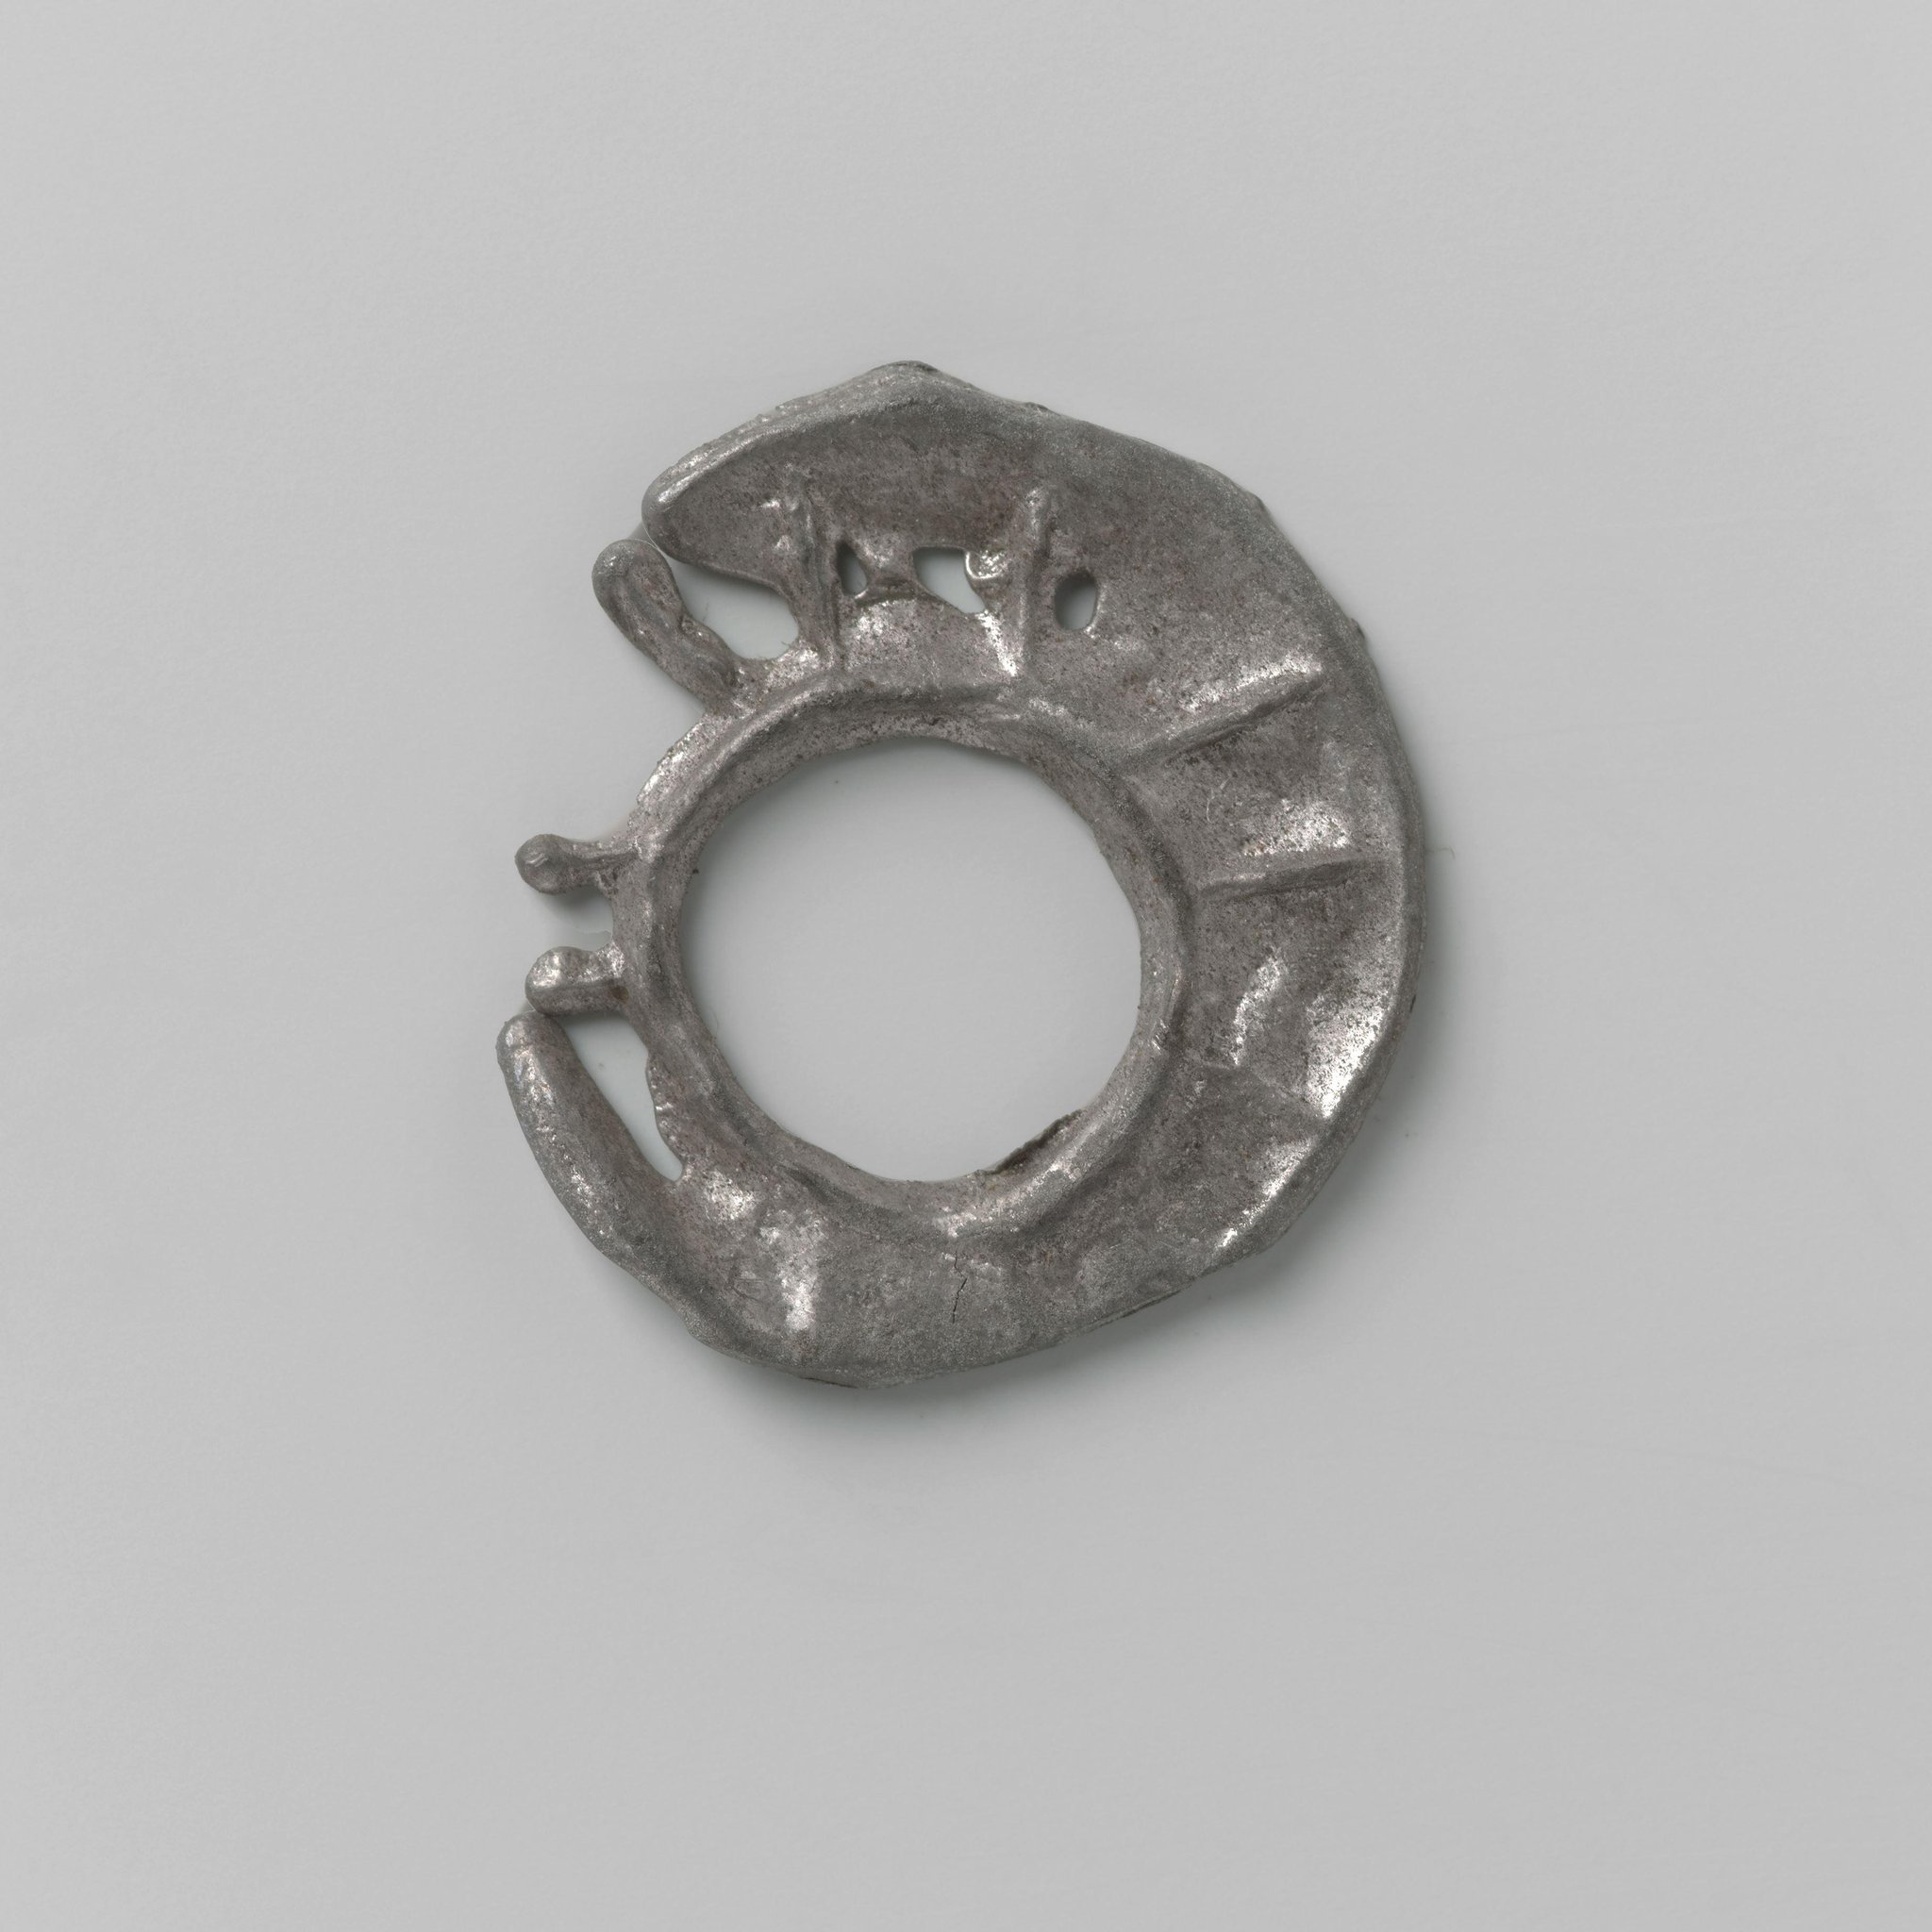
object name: coin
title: Pitji of keteng van Djokjakarta, Java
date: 1700-1800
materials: tin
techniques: casting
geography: soerakarta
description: Tinnen munt. Voorzijde: Omschrift in rudimentaire lettertekens. Keerzijde: glad. In het midden rond gat.